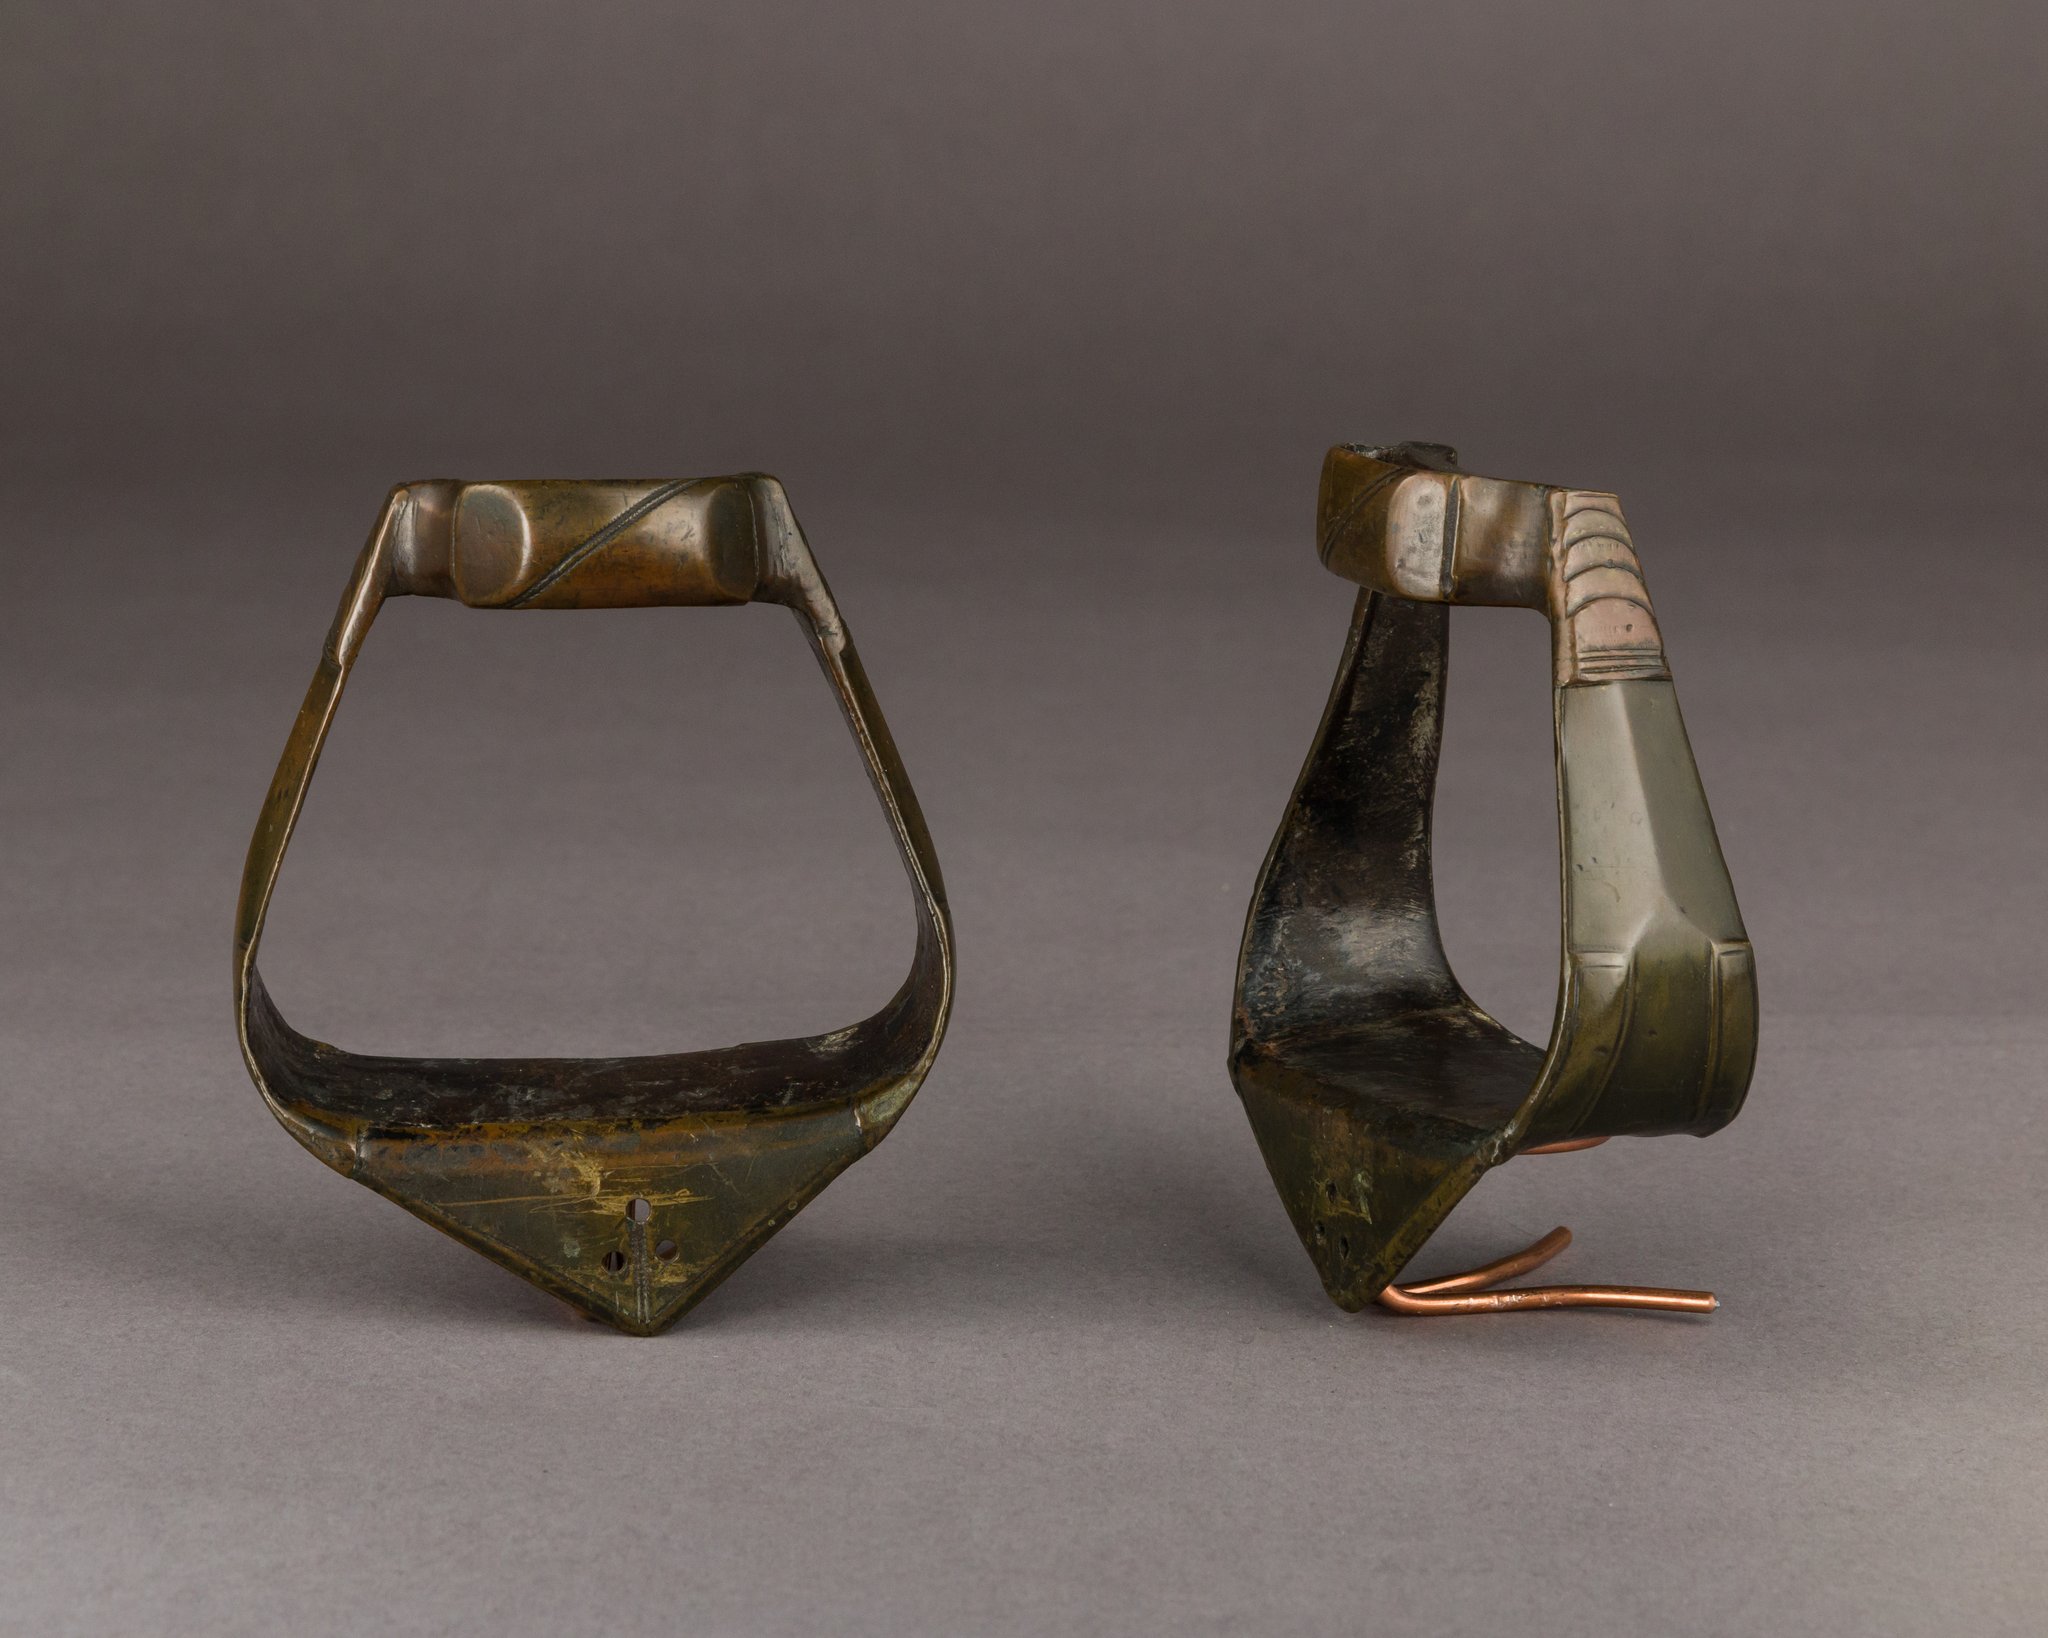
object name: stirrup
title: Pair of Stirrups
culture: german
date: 1500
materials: copper alloy, iron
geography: germany